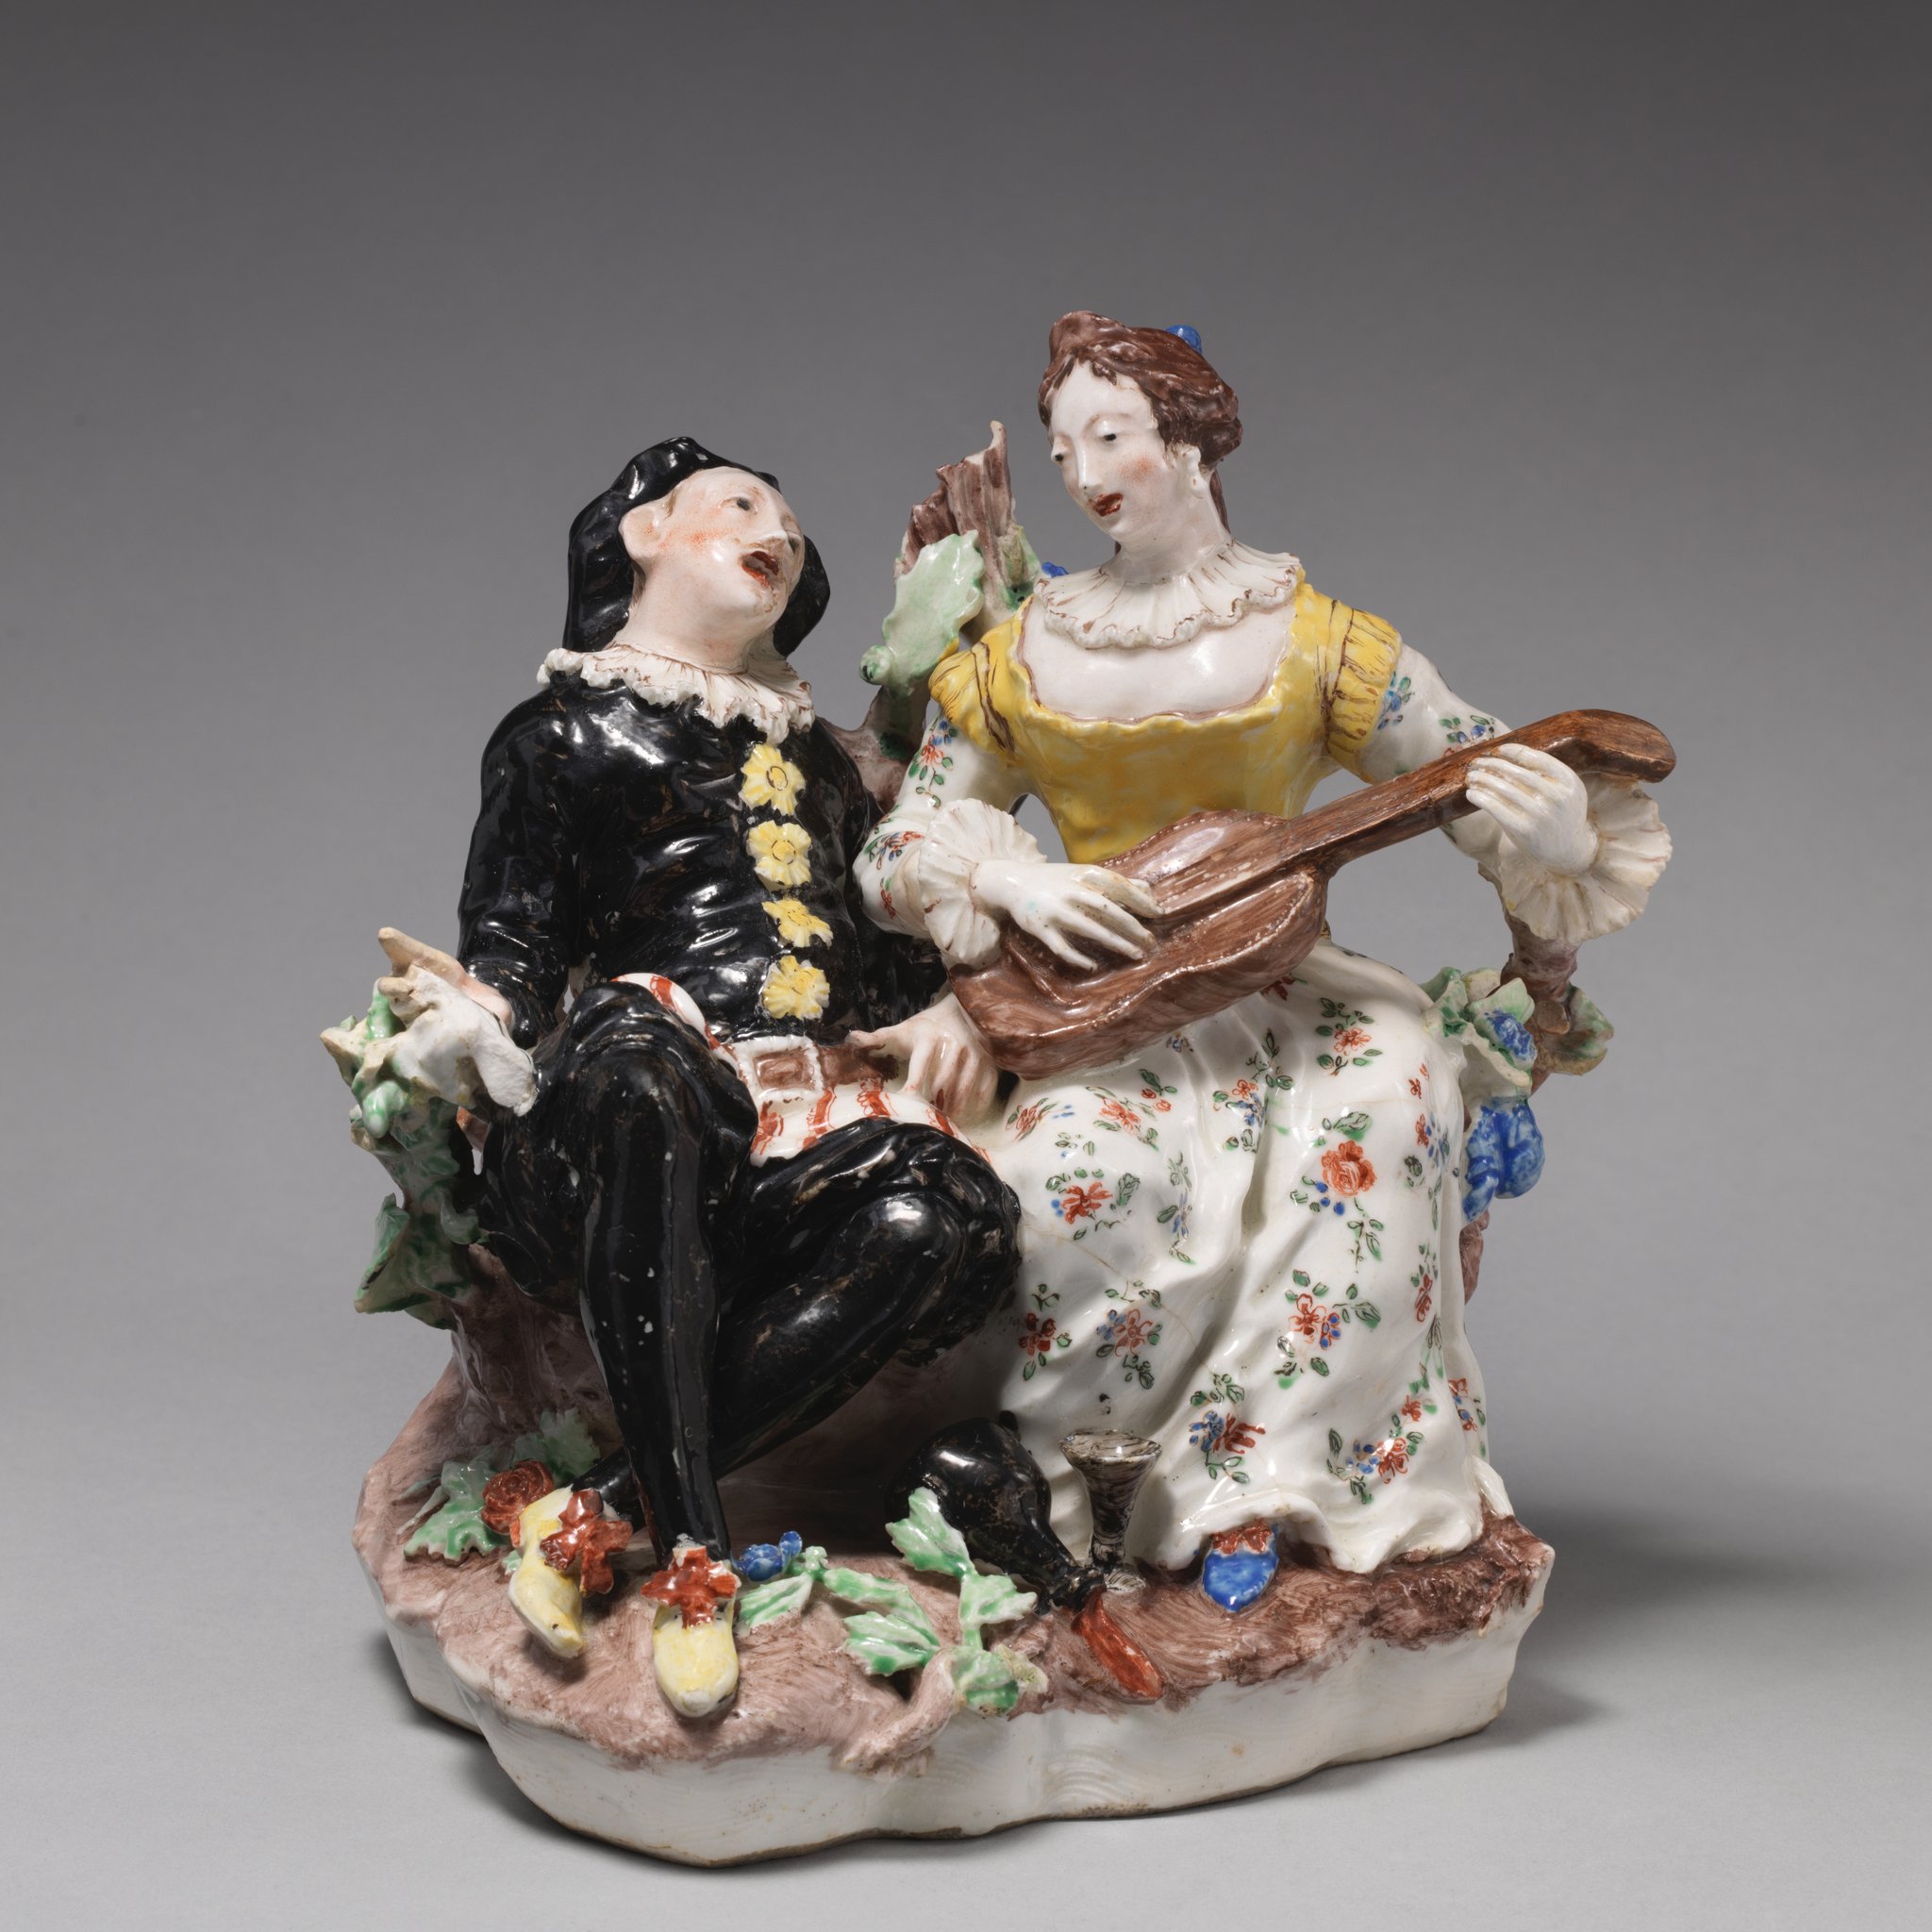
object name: group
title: Scaramouche and Isabella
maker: bow porcelain factory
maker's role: factory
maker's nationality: british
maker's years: 1747-1776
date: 1748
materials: soft paste porcelain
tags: musical instruments,men,women